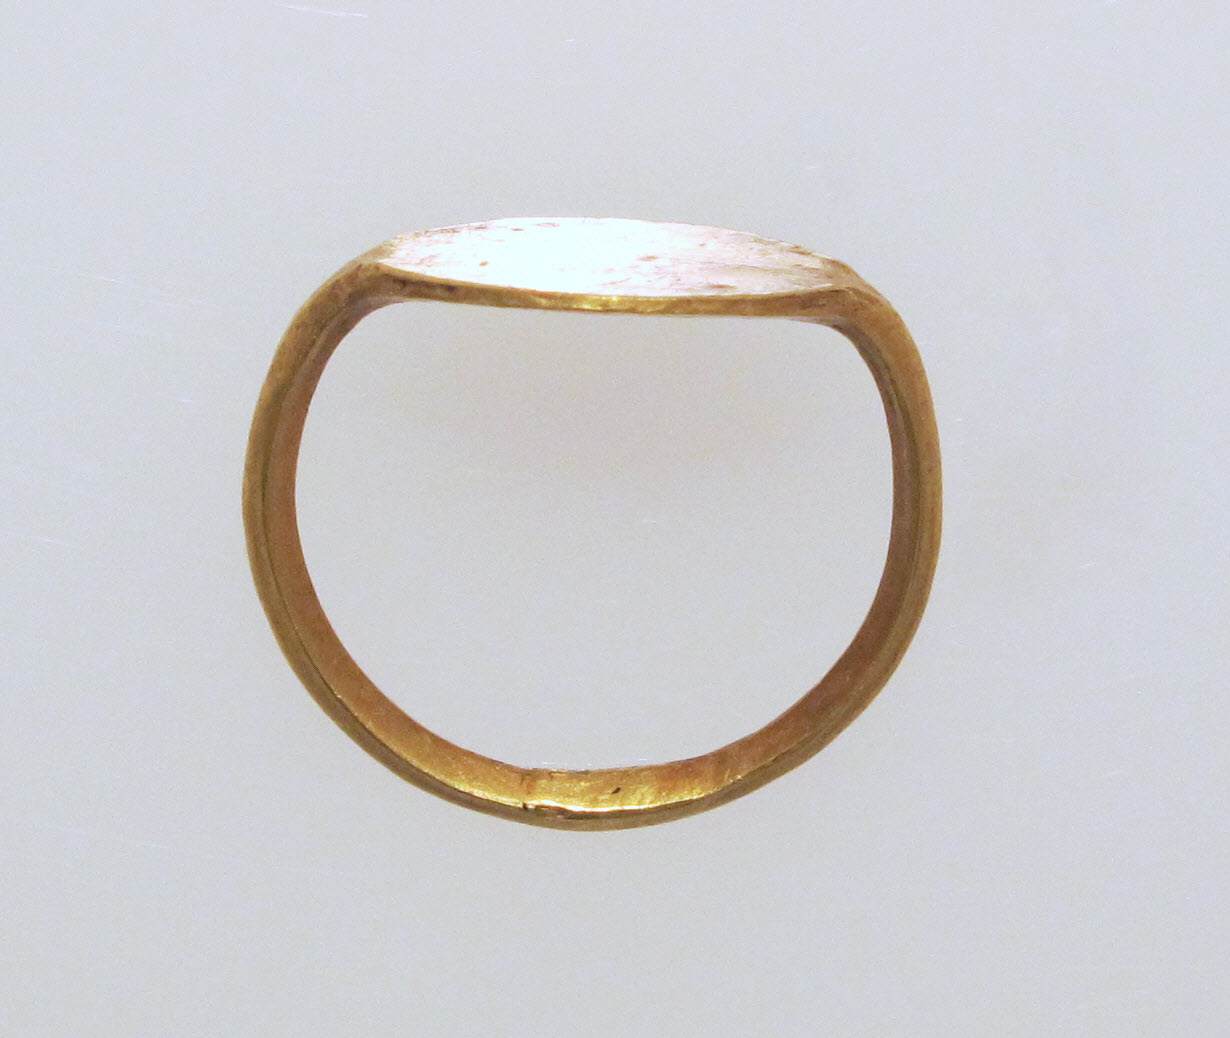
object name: ring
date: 7000 BCE-330 CE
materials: gold